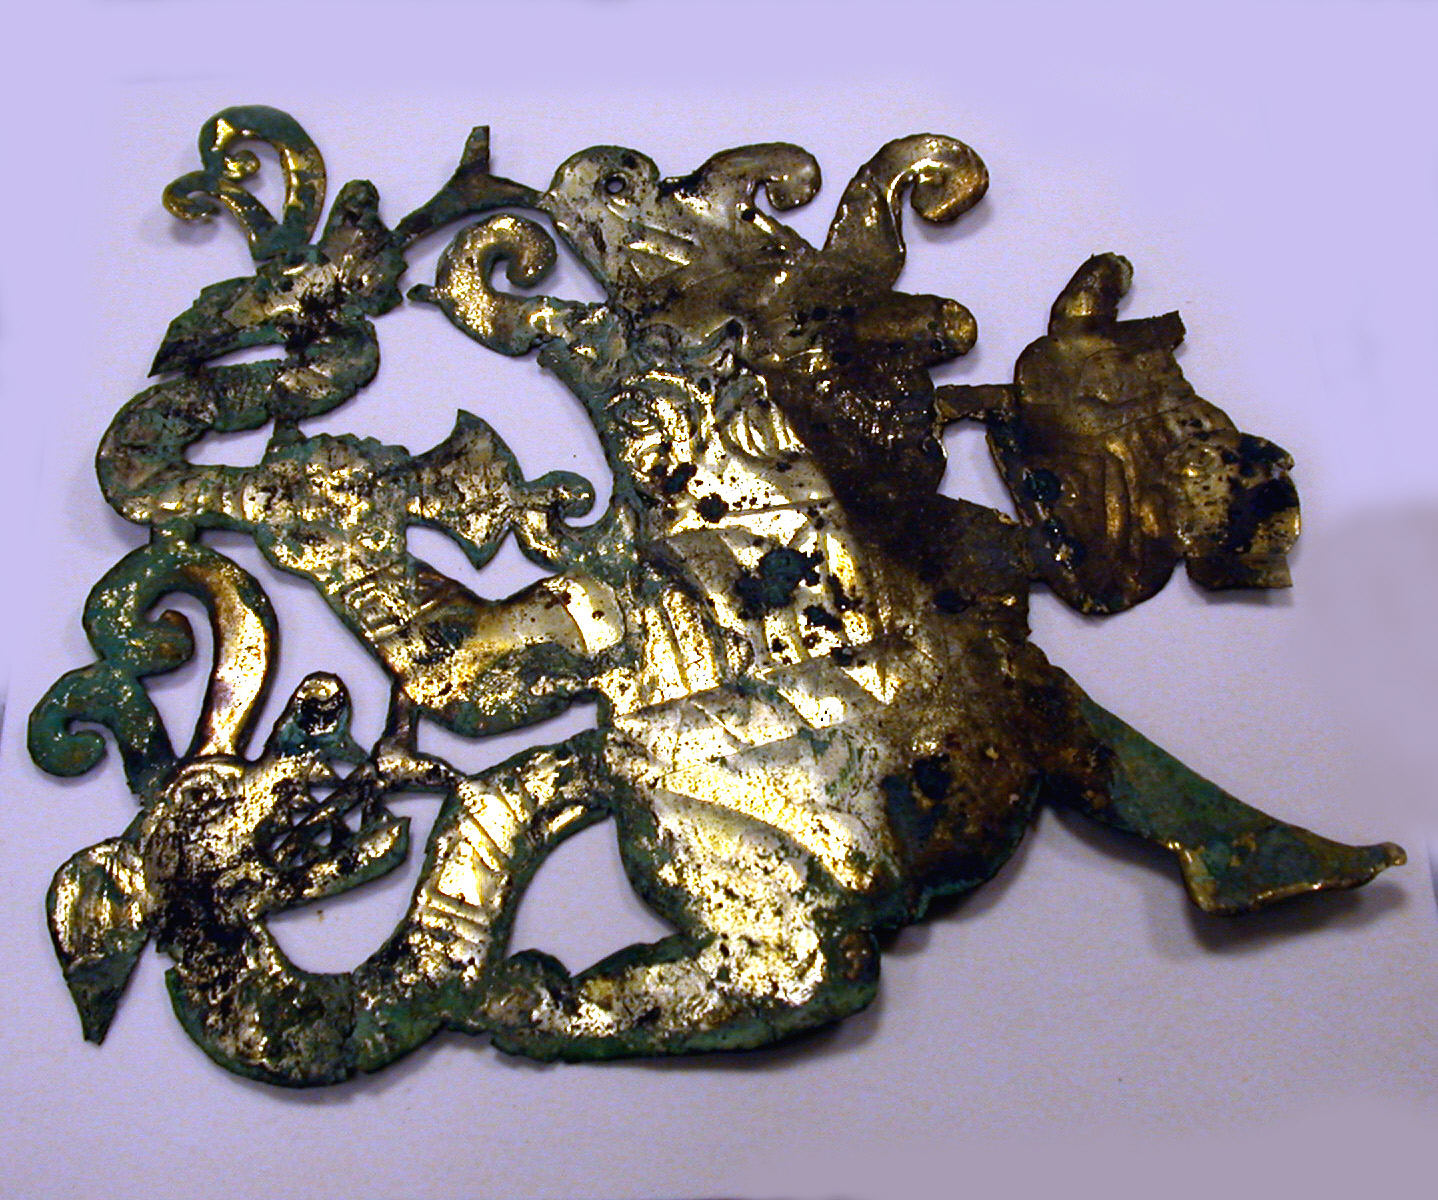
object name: ornament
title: Figure Ornament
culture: moche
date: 501-700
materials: metal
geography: peru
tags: men,serpents